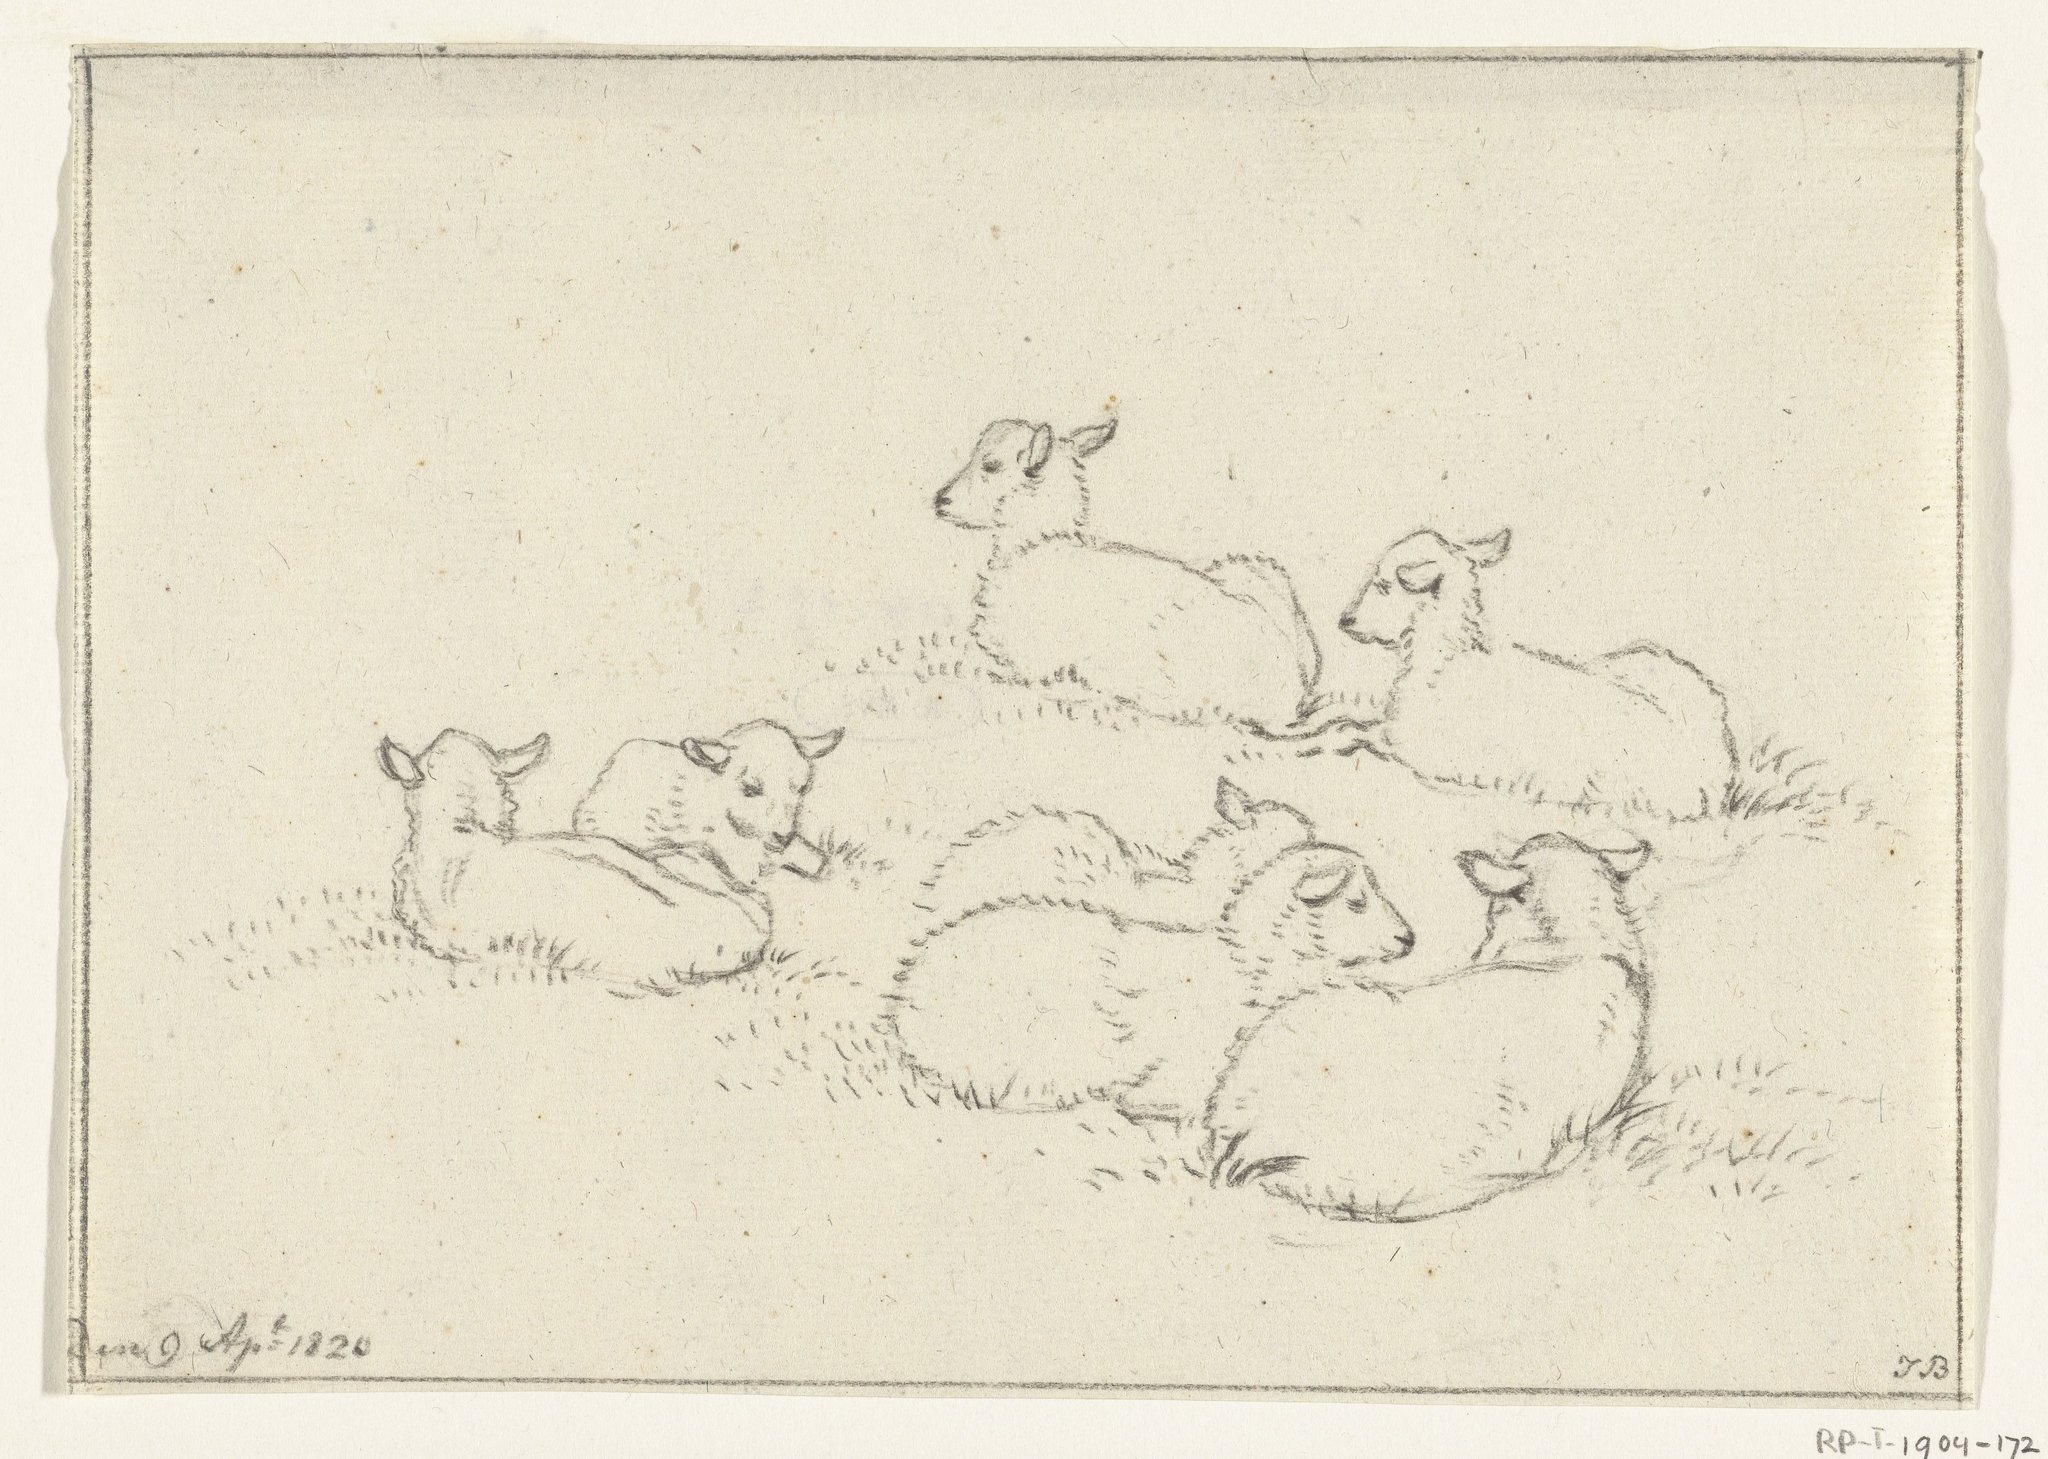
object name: drawing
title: Zes liggende lammetjes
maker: jean bernard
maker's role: draughtsman, print maker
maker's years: 1765-1833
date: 1820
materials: chalk, paper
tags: lamb